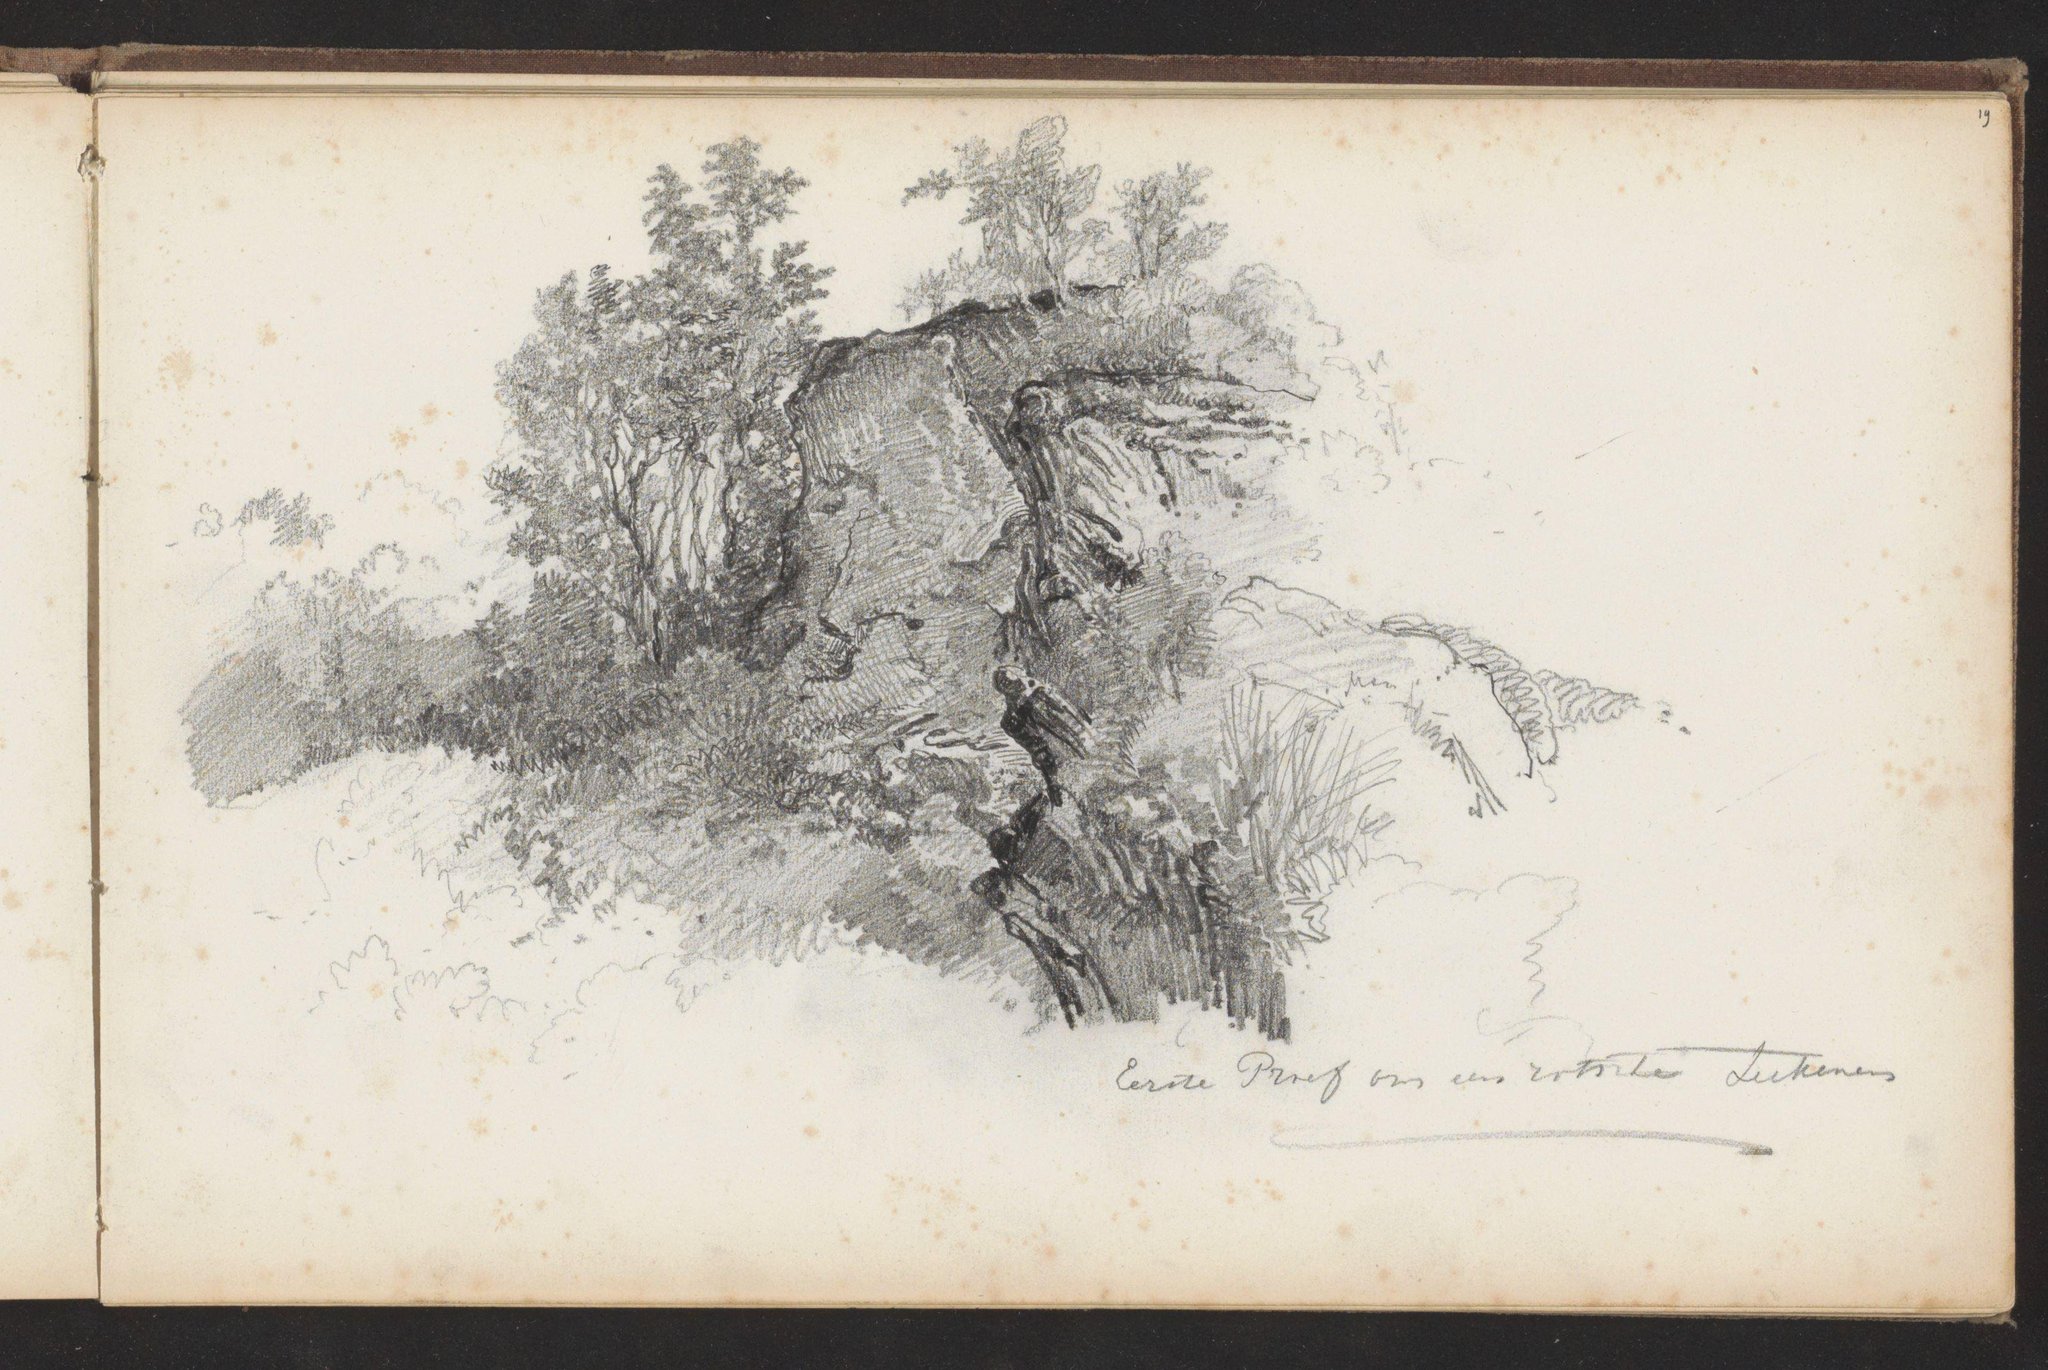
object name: sketchbook leaf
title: Rotsen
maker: maria vos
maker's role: draughtsman, painter, print maker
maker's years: 1824-1906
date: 1860-1865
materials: paper, pencil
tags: rocks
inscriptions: annotation: ‘Eerste Proef om eens rots te teekenen’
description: Blad 19 recto uit een schetsboek met 55 bladen.